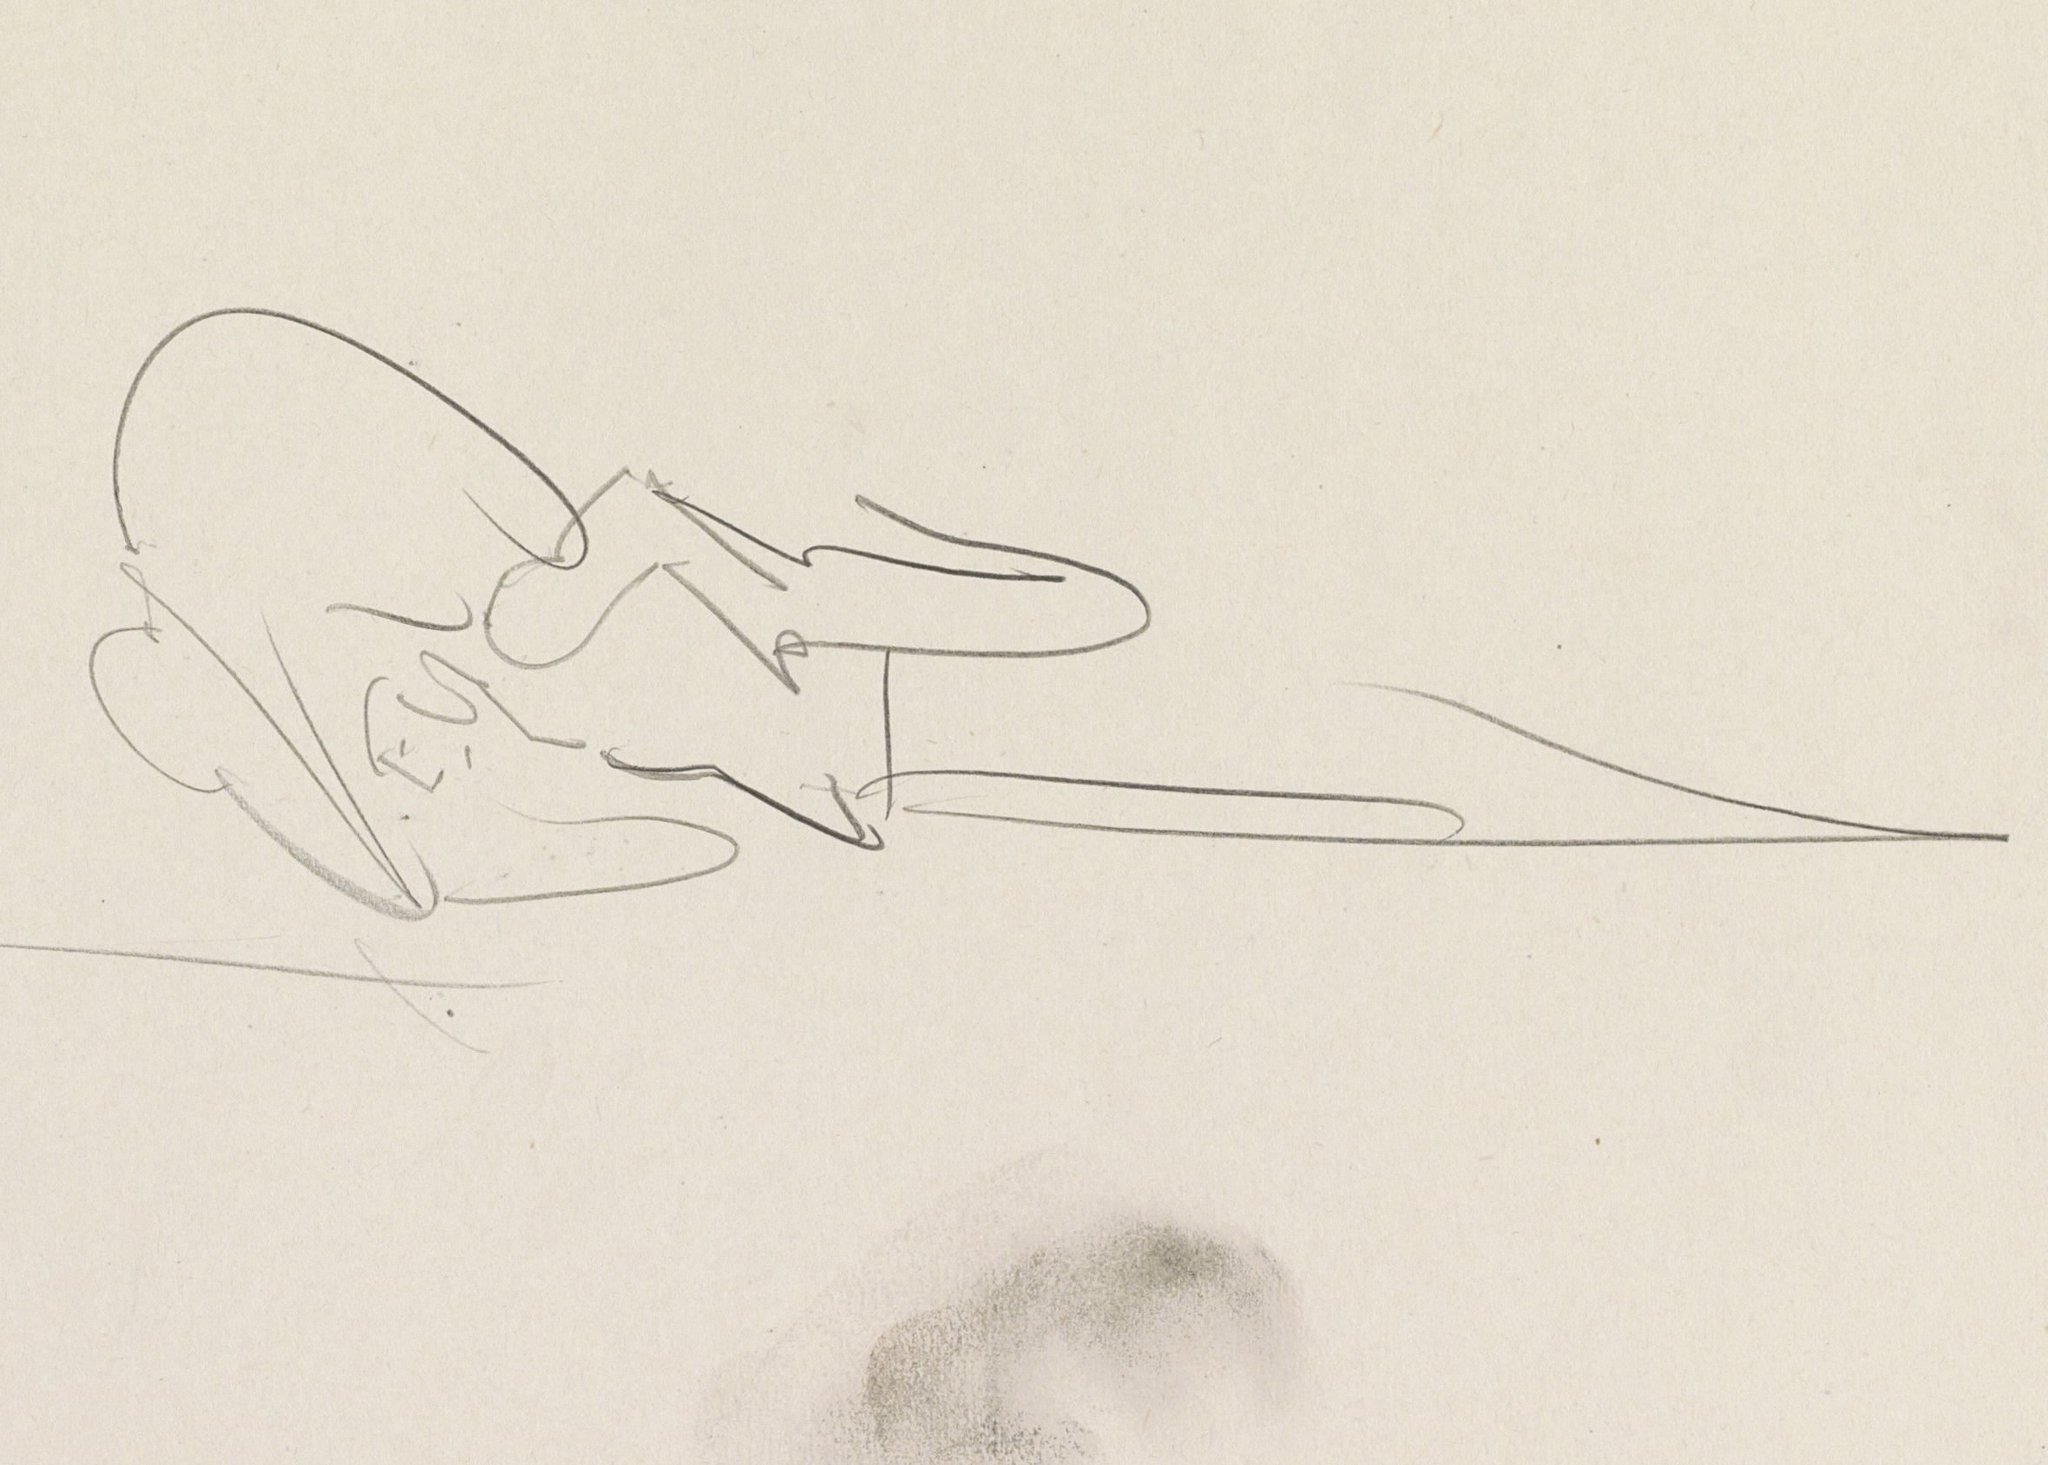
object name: sketchbook leaf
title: Figuurstudie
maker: isaac israels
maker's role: draughtsman, painter, print maker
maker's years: 1865-1934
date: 1875-1934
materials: paper, pencil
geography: the hague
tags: the (nude) human figure; 'corpo humano' (ripa)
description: Blad 3 recto uit schetsboek II met 23 bladen.